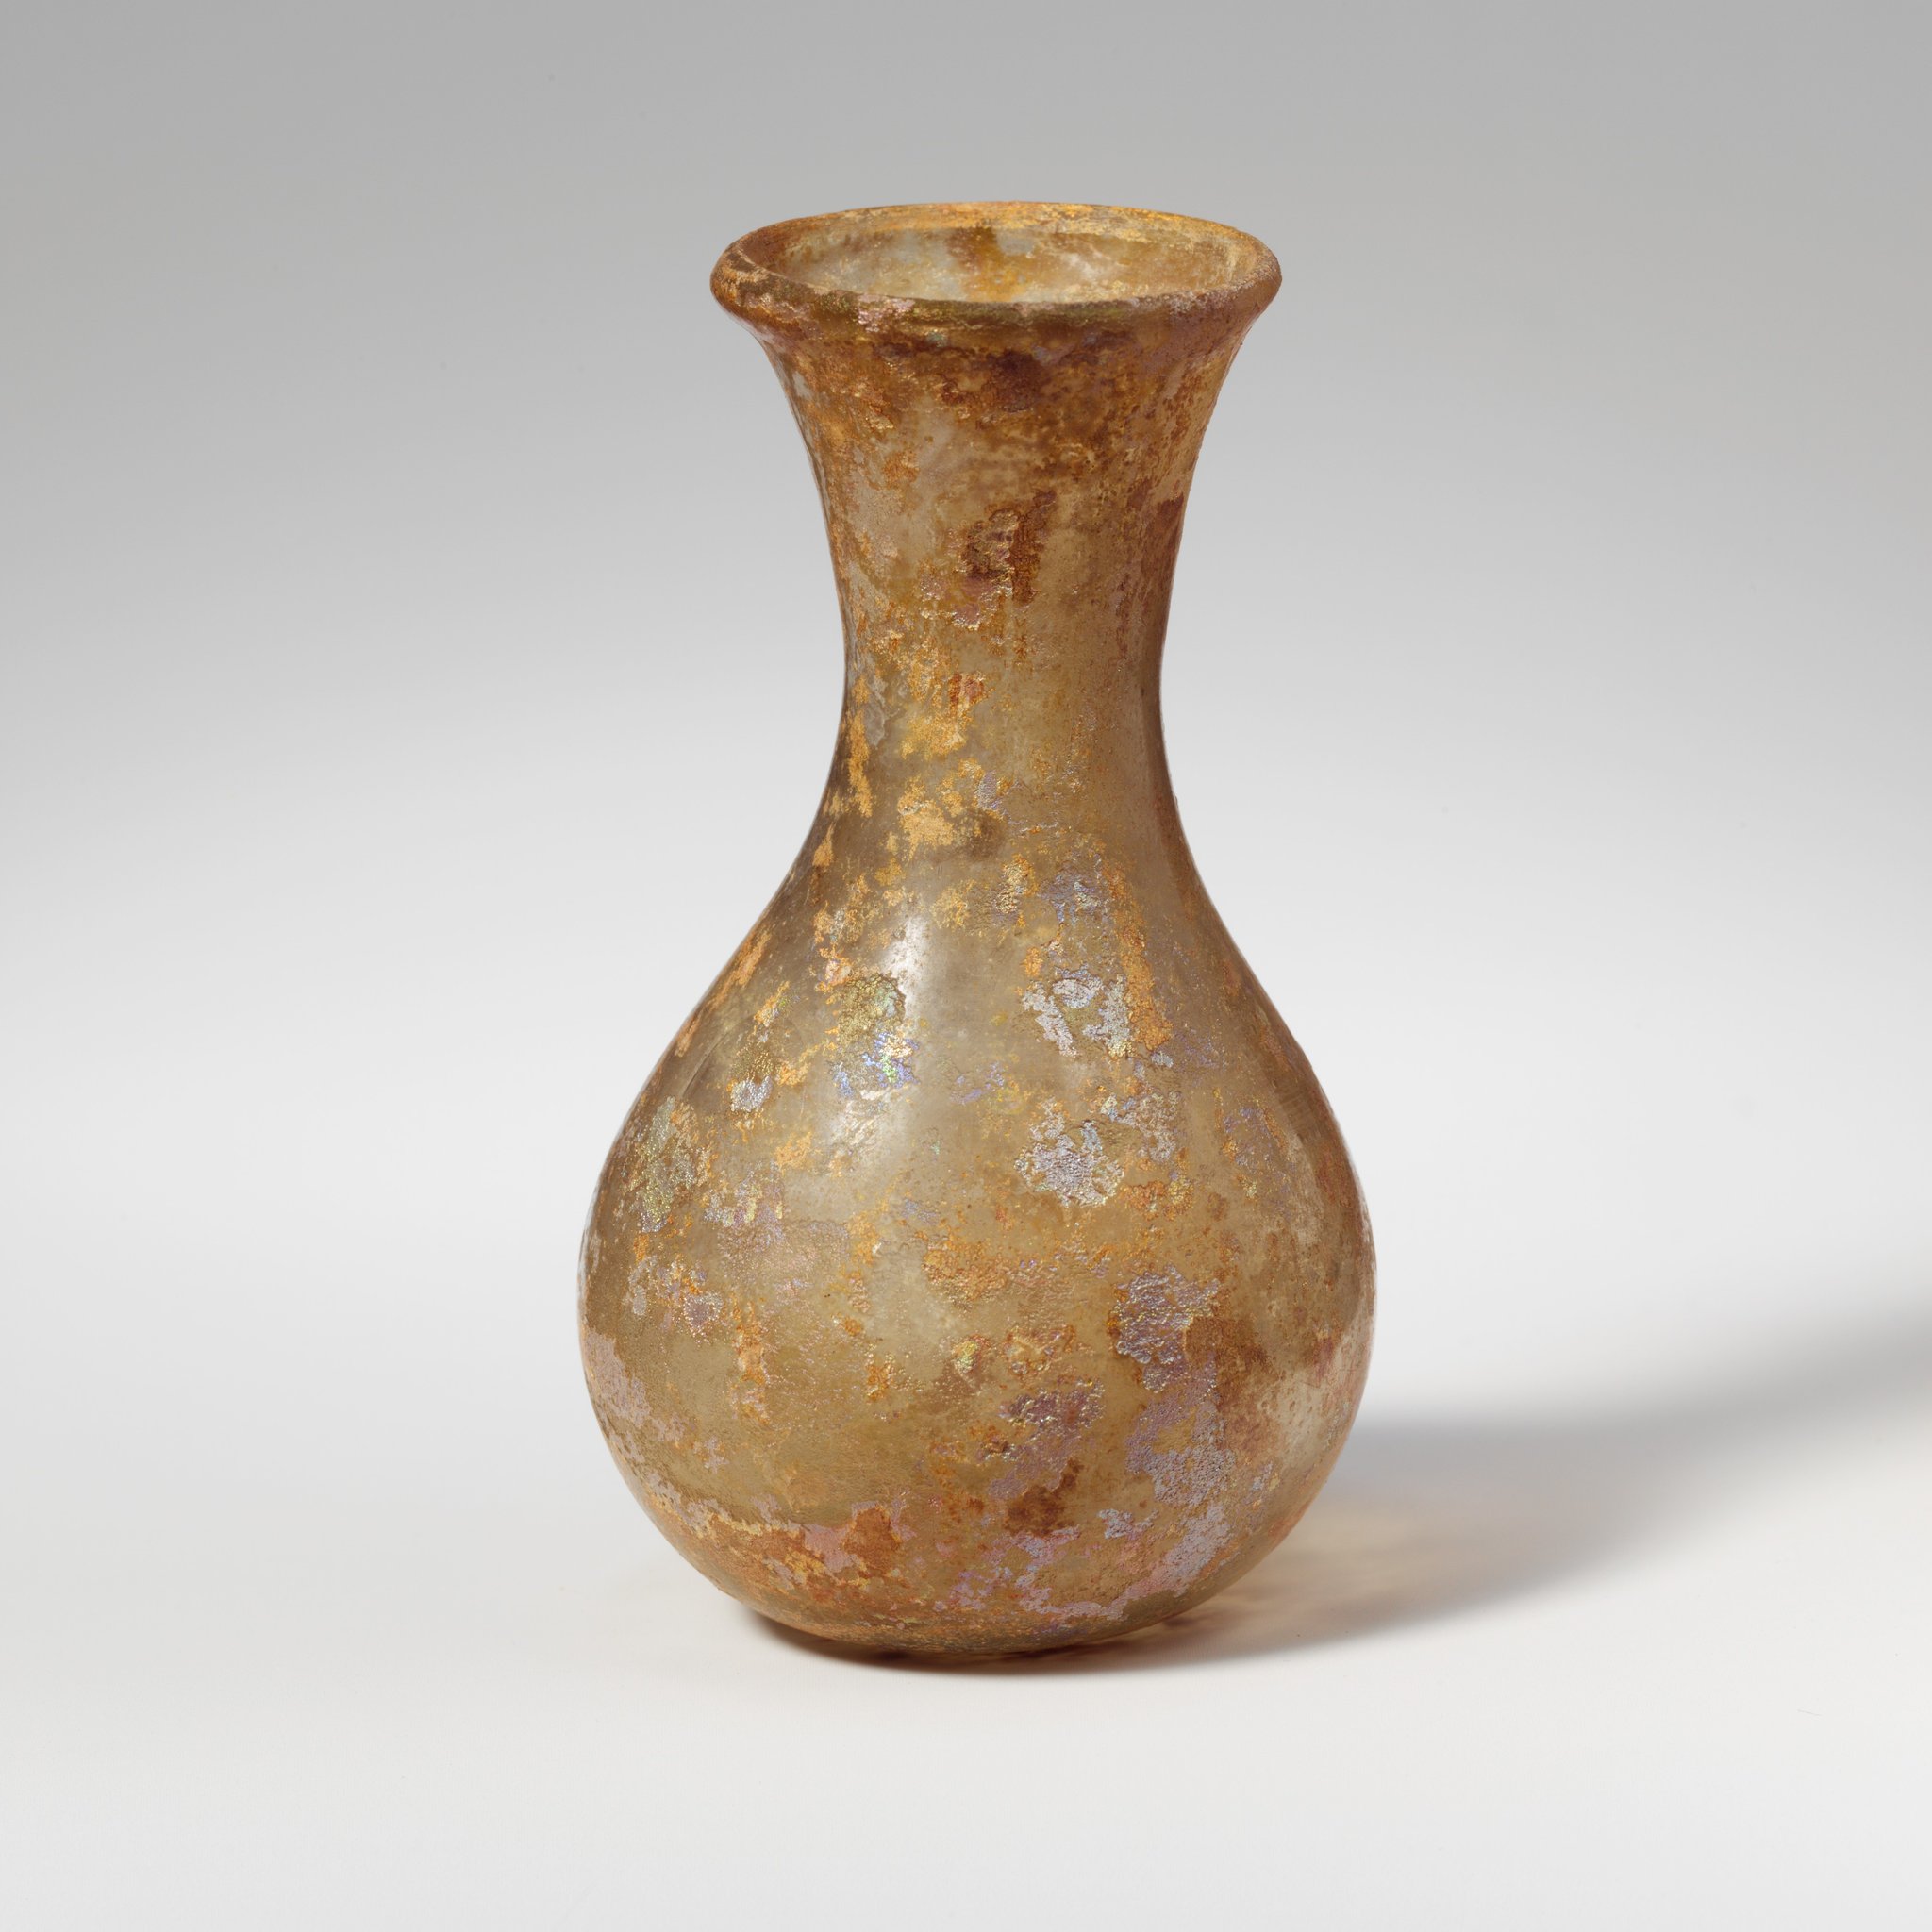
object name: flask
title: Glass flask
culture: roman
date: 201-400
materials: glass